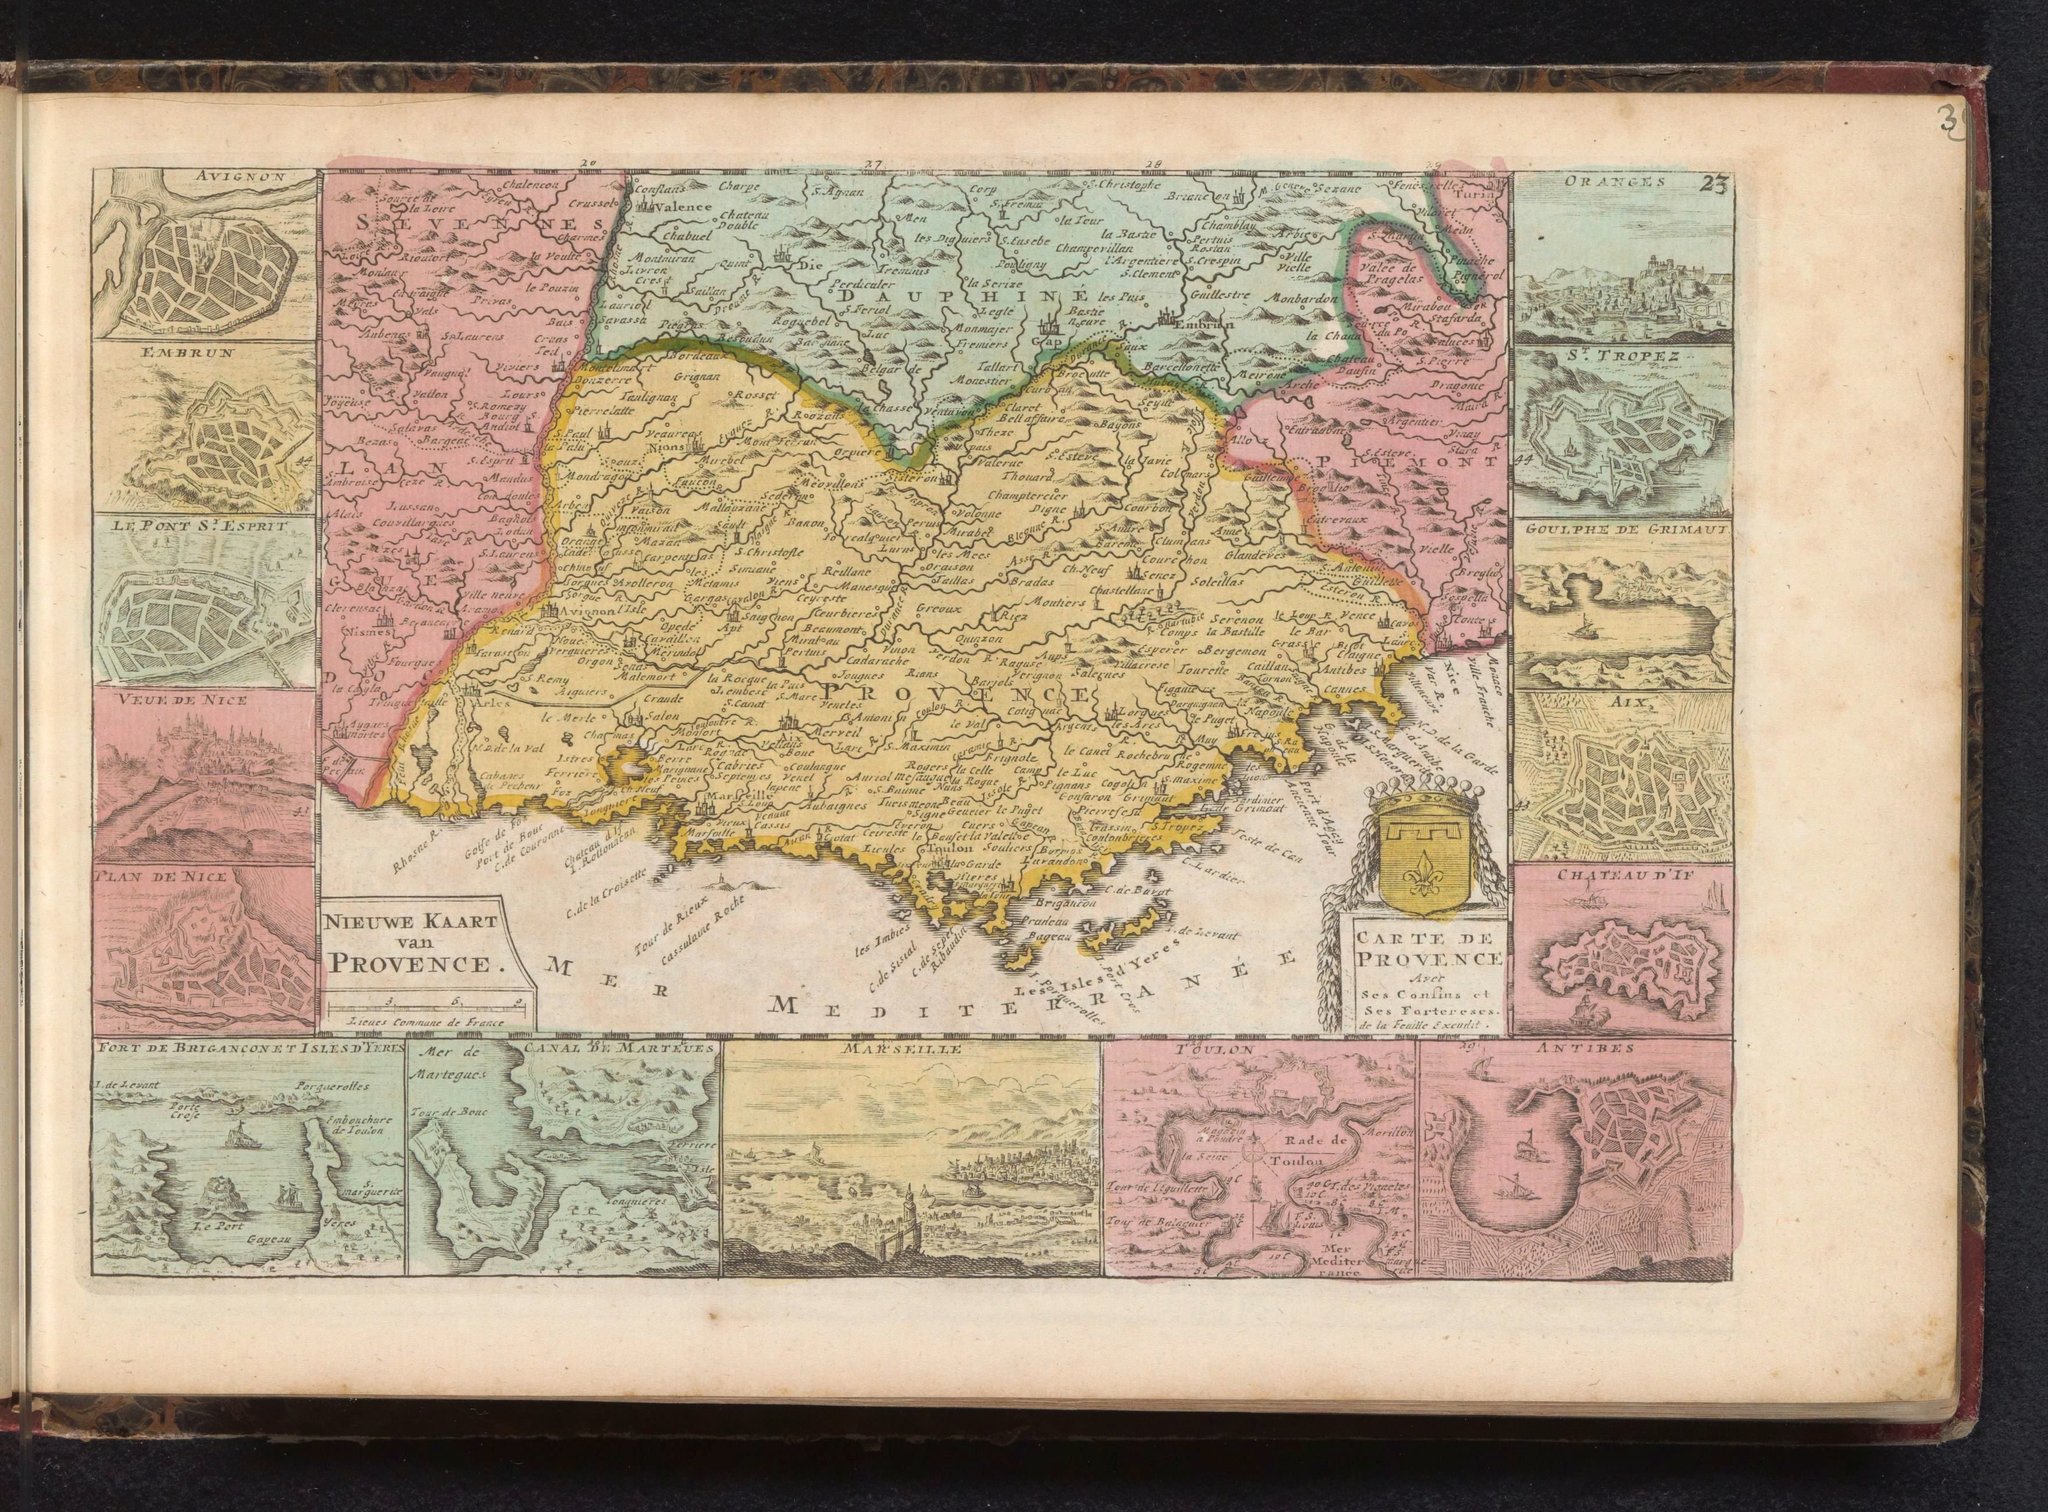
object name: print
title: Kaart van de Provence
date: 1700-1706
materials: paper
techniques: engraving, etching, hand coloring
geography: northern netherlands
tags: maps of separate countries or regions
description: Kaart van de Provence in Frankrijk, om de kaart vijftien kleinere plattegronden en gezichten op steden. Onderdeel van een atlas met 223 kaarten van landen en steden en oorlogstaferelen in Europa in de periode ca. 1690-1735.